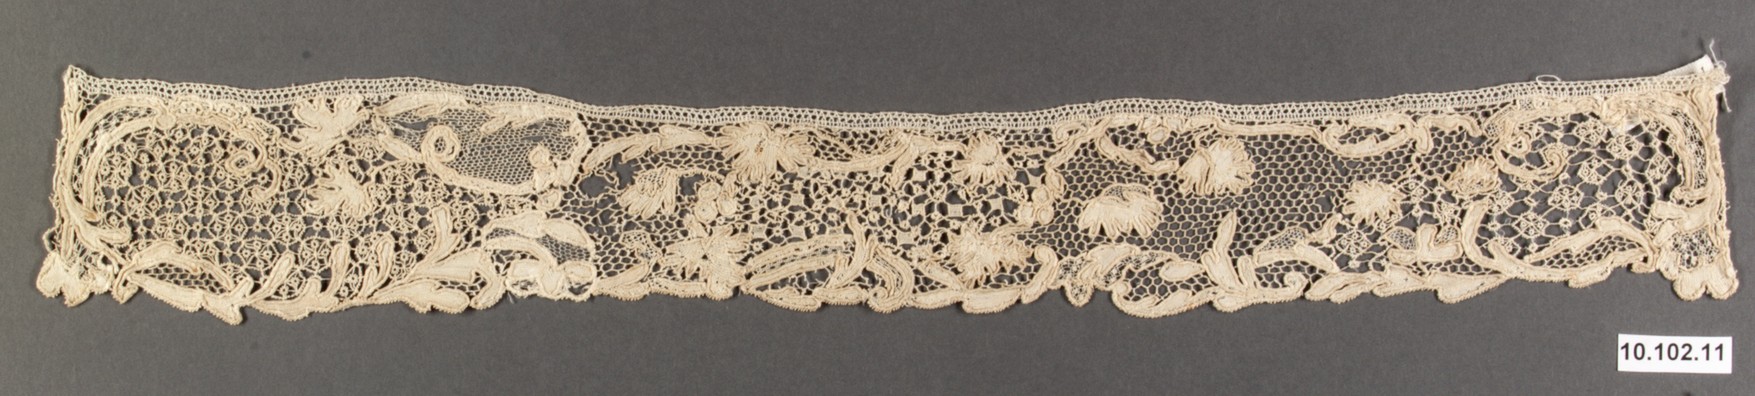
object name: fragment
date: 1701-1800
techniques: lace